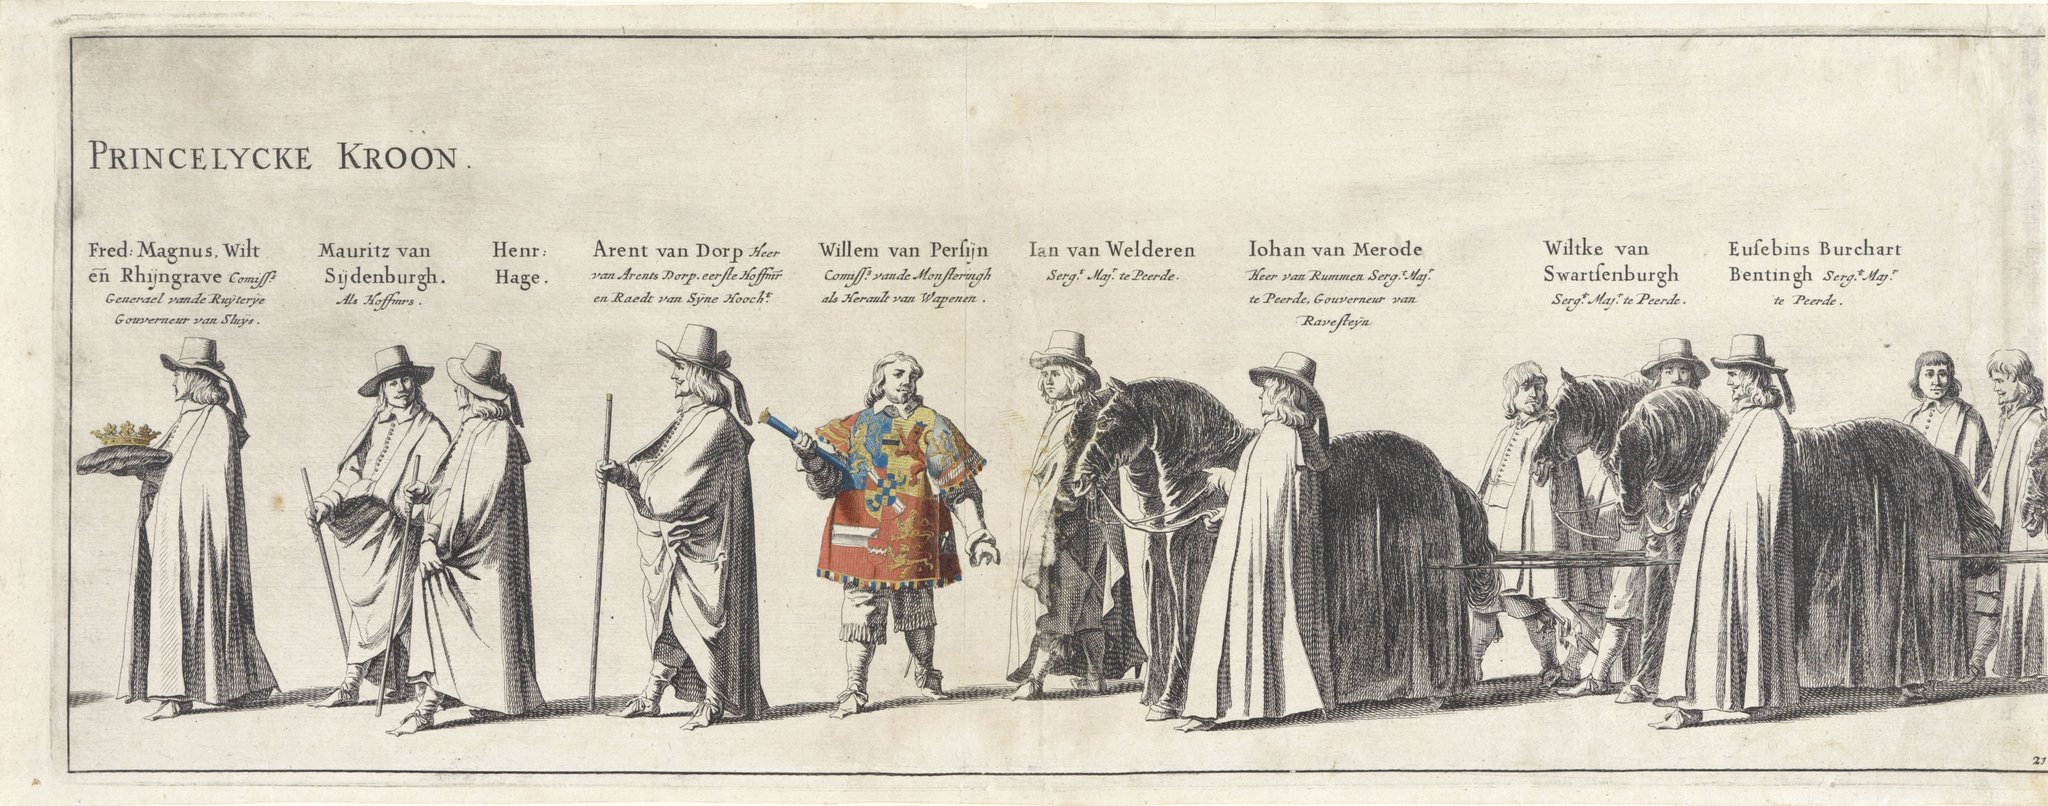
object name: print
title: Trofee bij het portret van Leonardos Philaras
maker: claude mellan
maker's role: draughtsman, print maker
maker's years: 1598-1688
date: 1651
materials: paper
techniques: engraving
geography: france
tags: trophy, i.e.: decorative arrangement of symbolic or typical objects ~ ornament, historical persons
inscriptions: collector's mark: Lugt 240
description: Deze prent hoort bij het portret van Leonardos Philaras. Zie RP-P-OB-69.997.